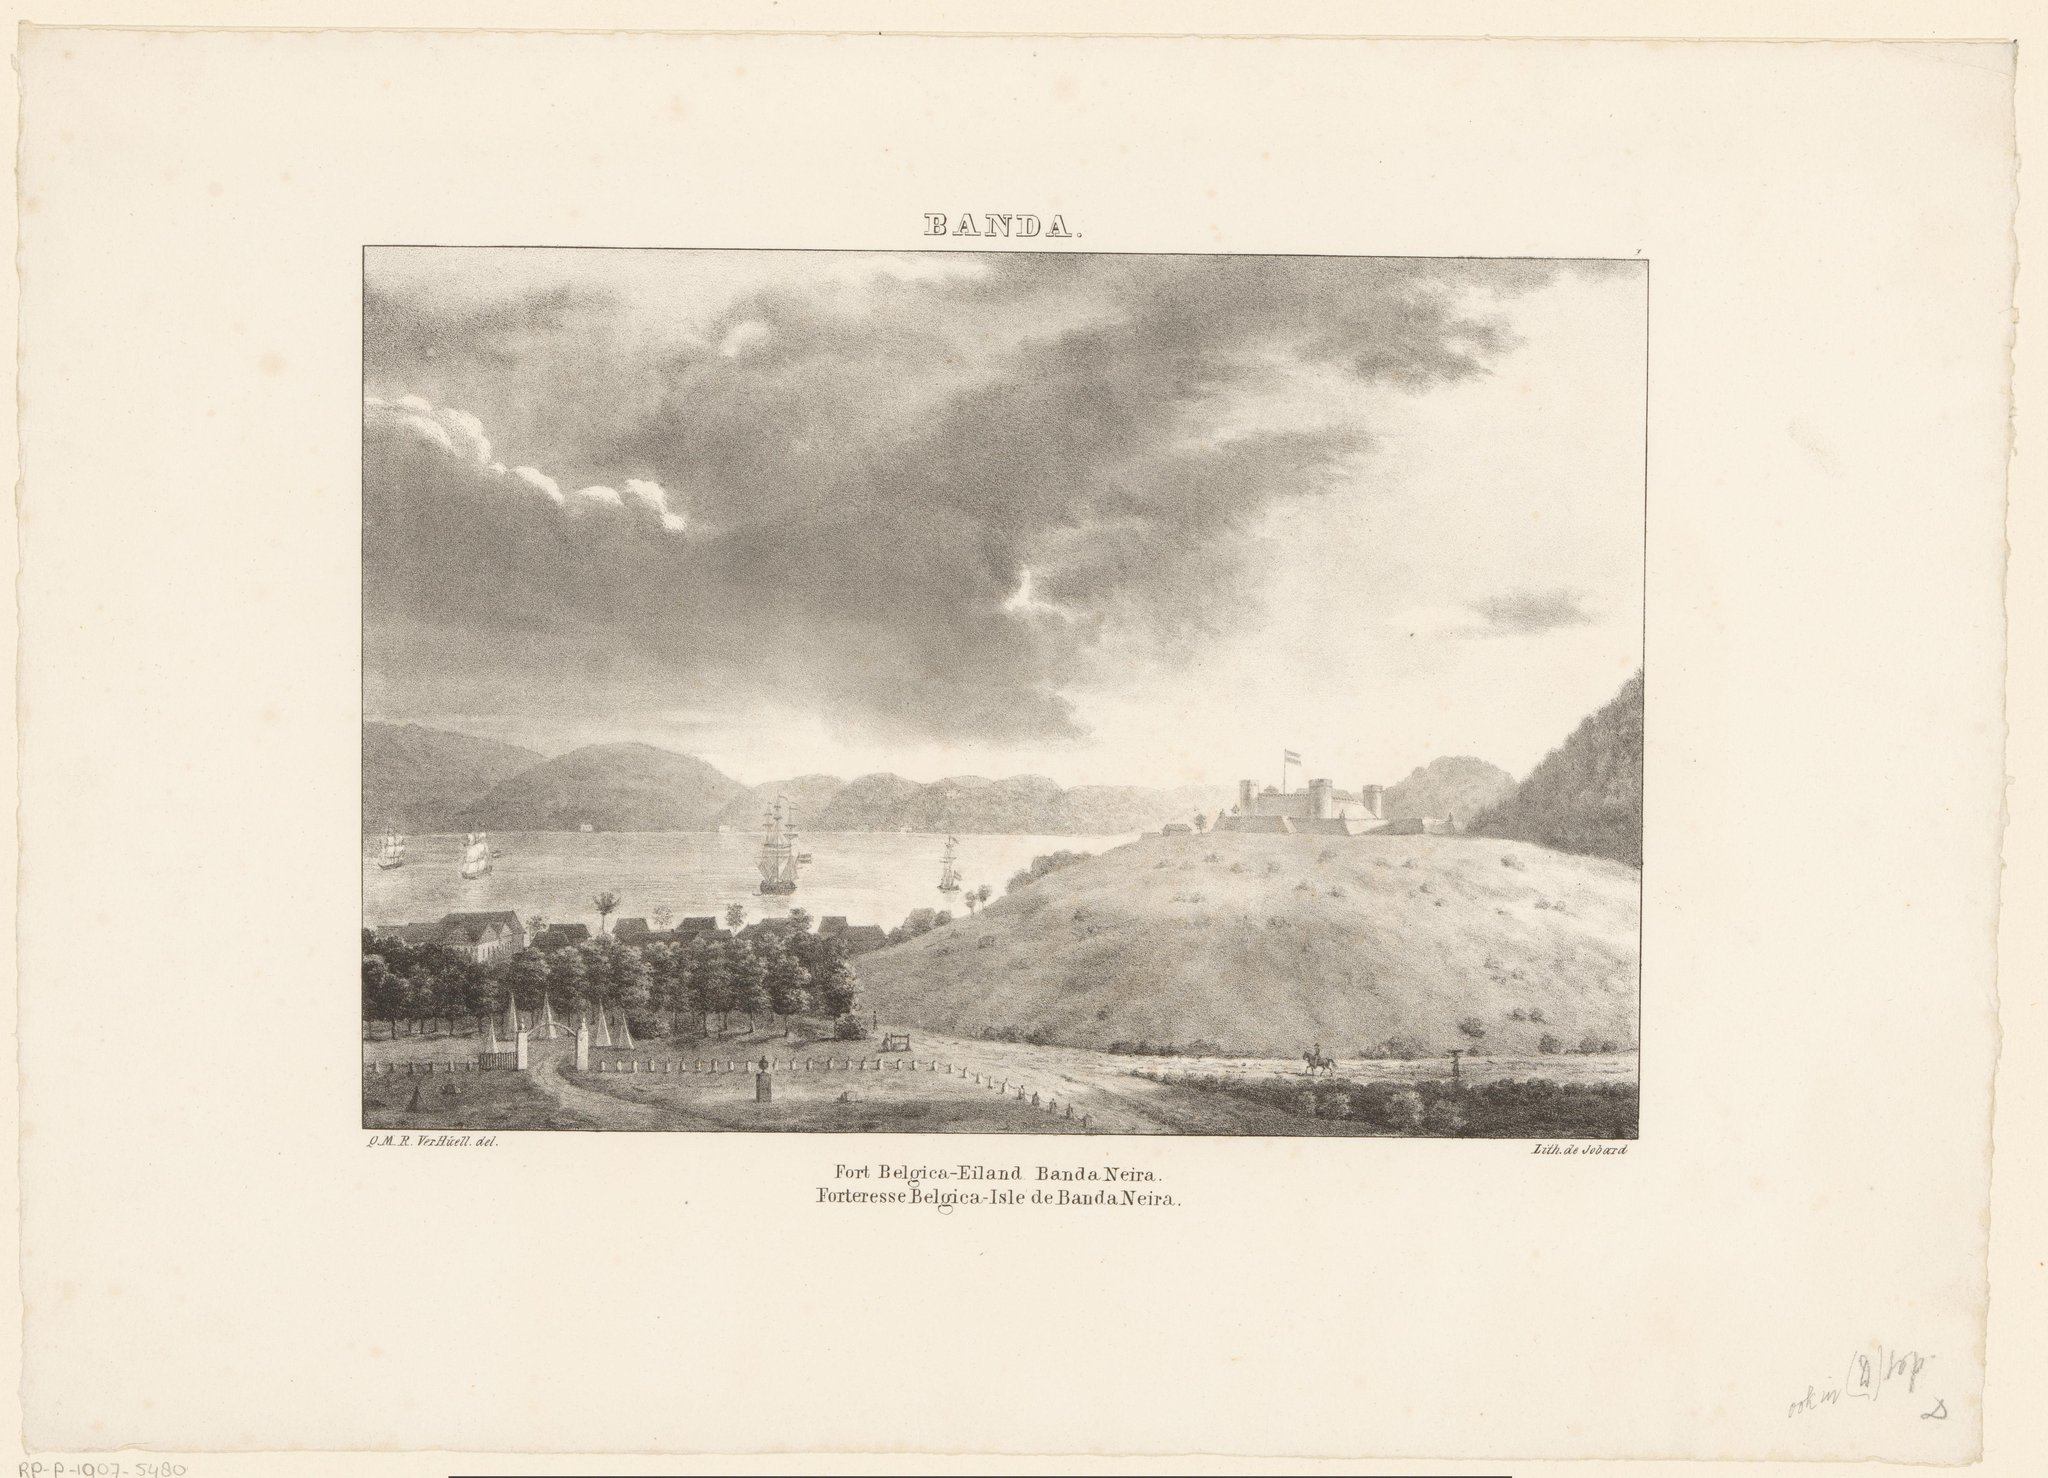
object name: print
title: Banda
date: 1824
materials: paper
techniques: lithograph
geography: rotterdam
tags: fortress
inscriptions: inscription: ‘4 / 13-1-'75’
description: Schepen op kalm water met rechts op een heuvel fort Belgica en links de huizen te Bandaneira.